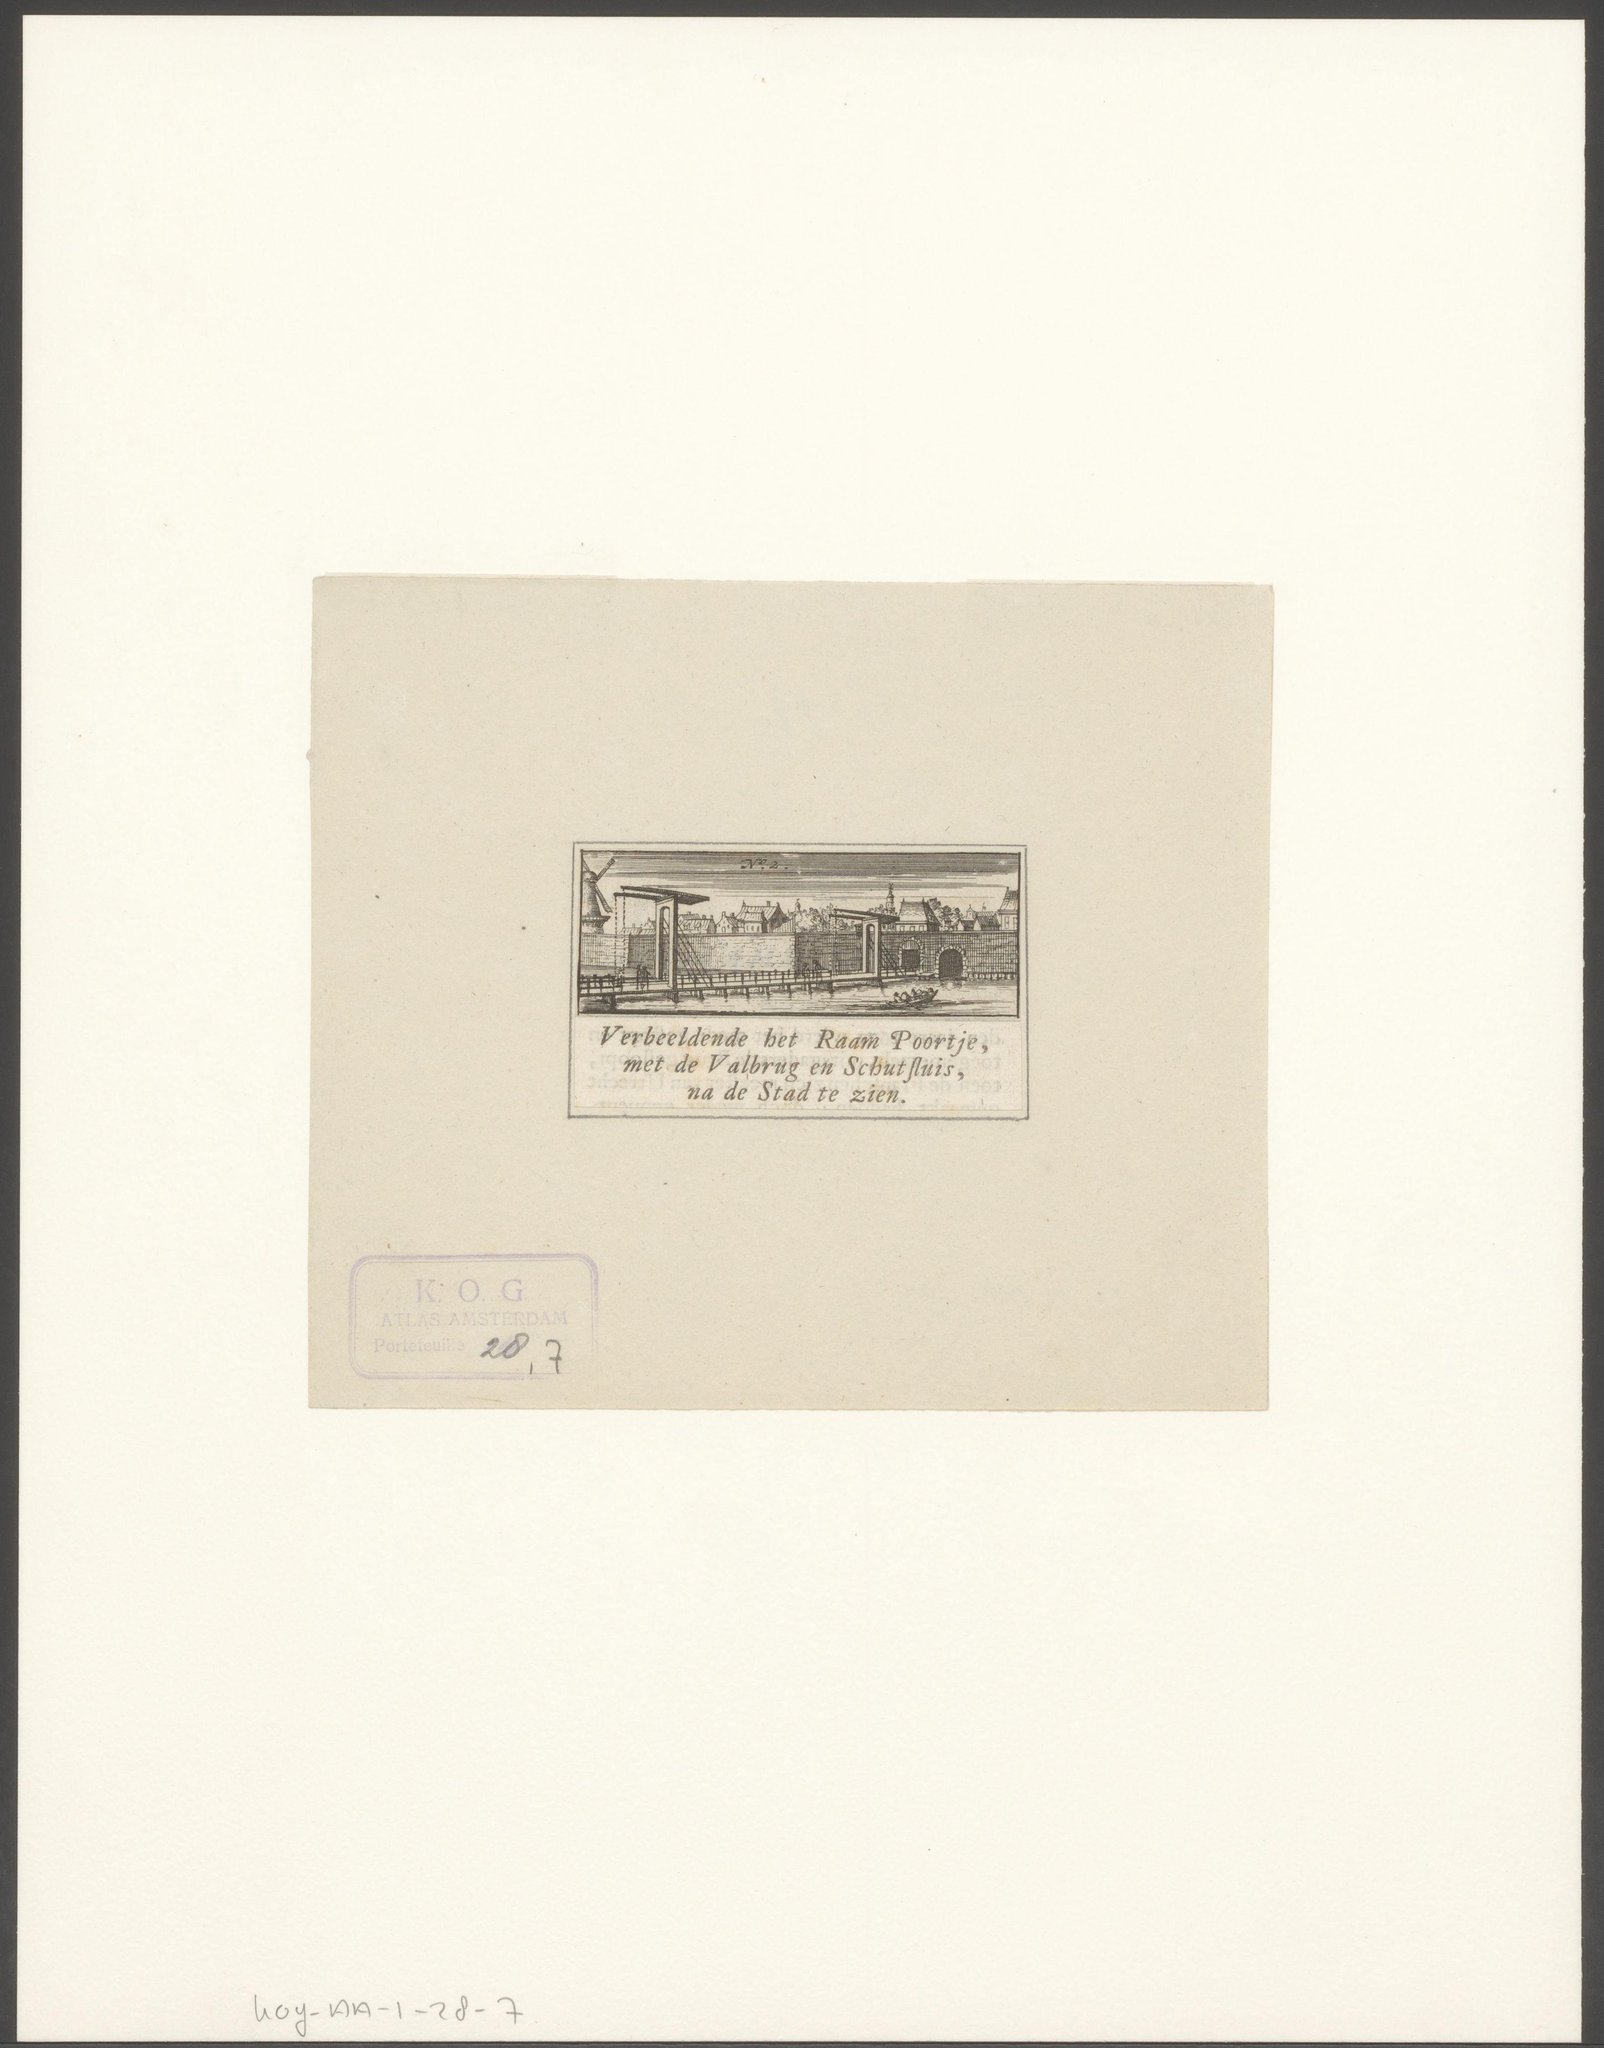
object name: print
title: Gezicht op de Raampoort te Amsterdam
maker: jan lamsvelt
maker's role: print maker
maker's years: 1674-1743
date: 1741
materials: paper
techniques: etching, letterpress printing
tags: city-gate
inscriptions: collector's mark: Lugt 1641b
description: Prent waarschijnlijk uit: Gebouwen, gezichten, en oudheden Der Stad Amsterdam. Haarlem: Johannes Marshoorn, 1741. Prent eerder gebruikt in: Leuve, Roeland van. 's Waerelds koopslot of De Amsteldamse beurs. Amsterdam: Jacobus Verheyden (I), 1723.